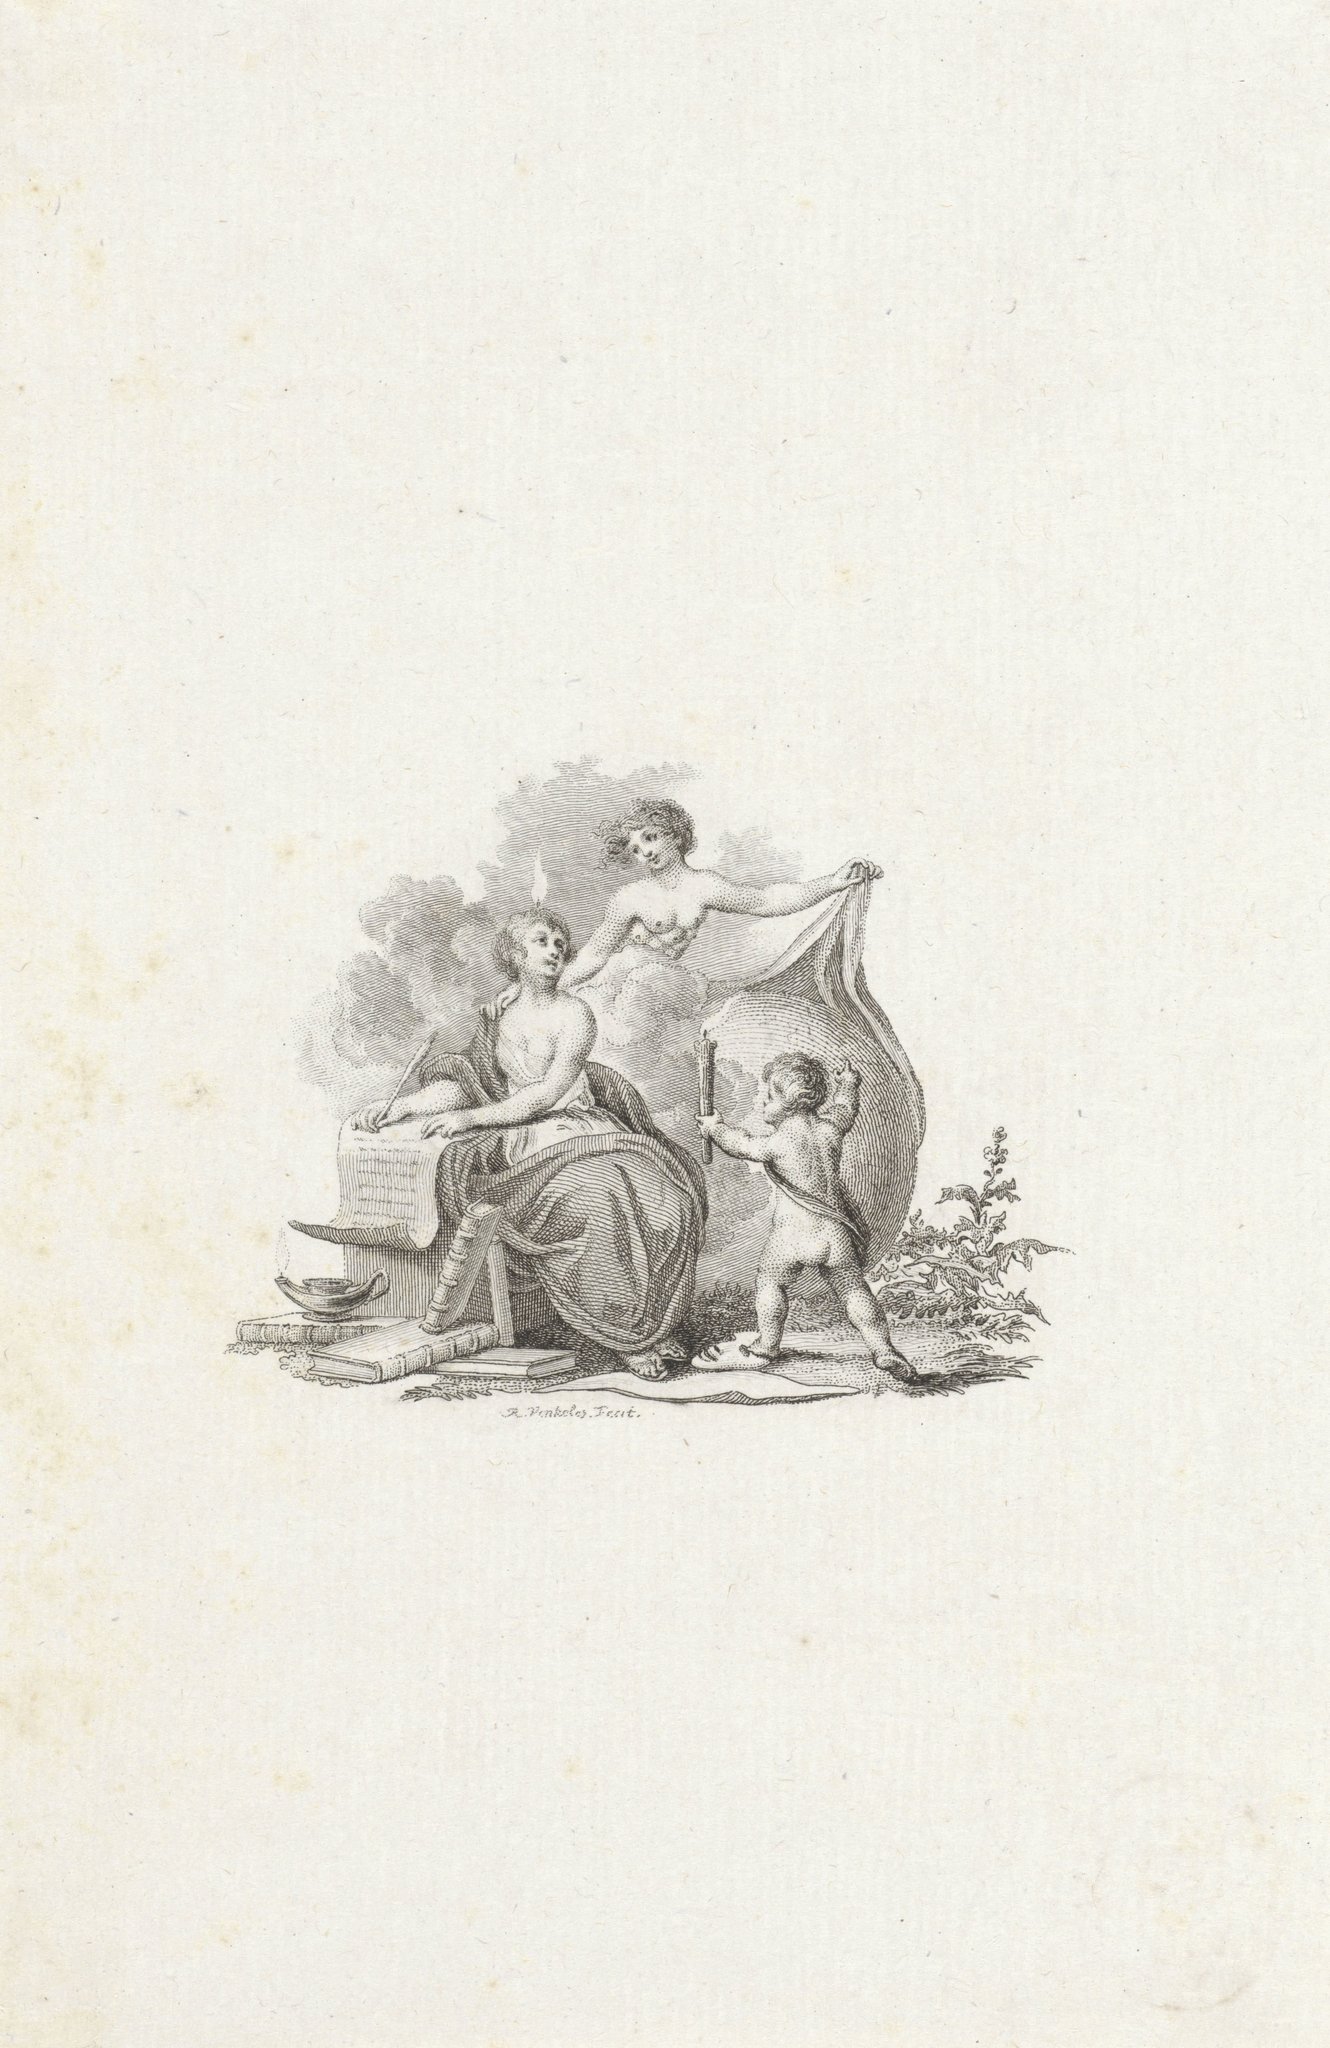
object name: print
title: Vignet voor: A.C. Watier, 'De Lierzang'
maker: reinier vinkeles (i)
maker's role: draughtsman, print maker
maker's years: 1741-1816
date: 1751-1816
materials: paper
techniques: etching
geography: amsterdam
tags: handwriting, written text, cupids: 'amores', 'amoretti', 'putti'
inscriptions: collector's mark: Lugt 240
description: Een putto met een brandende kaars wijst de schrijvende personificatie van Geloof op de personificatie van Vruchtbaarheid die de aarde onthult.